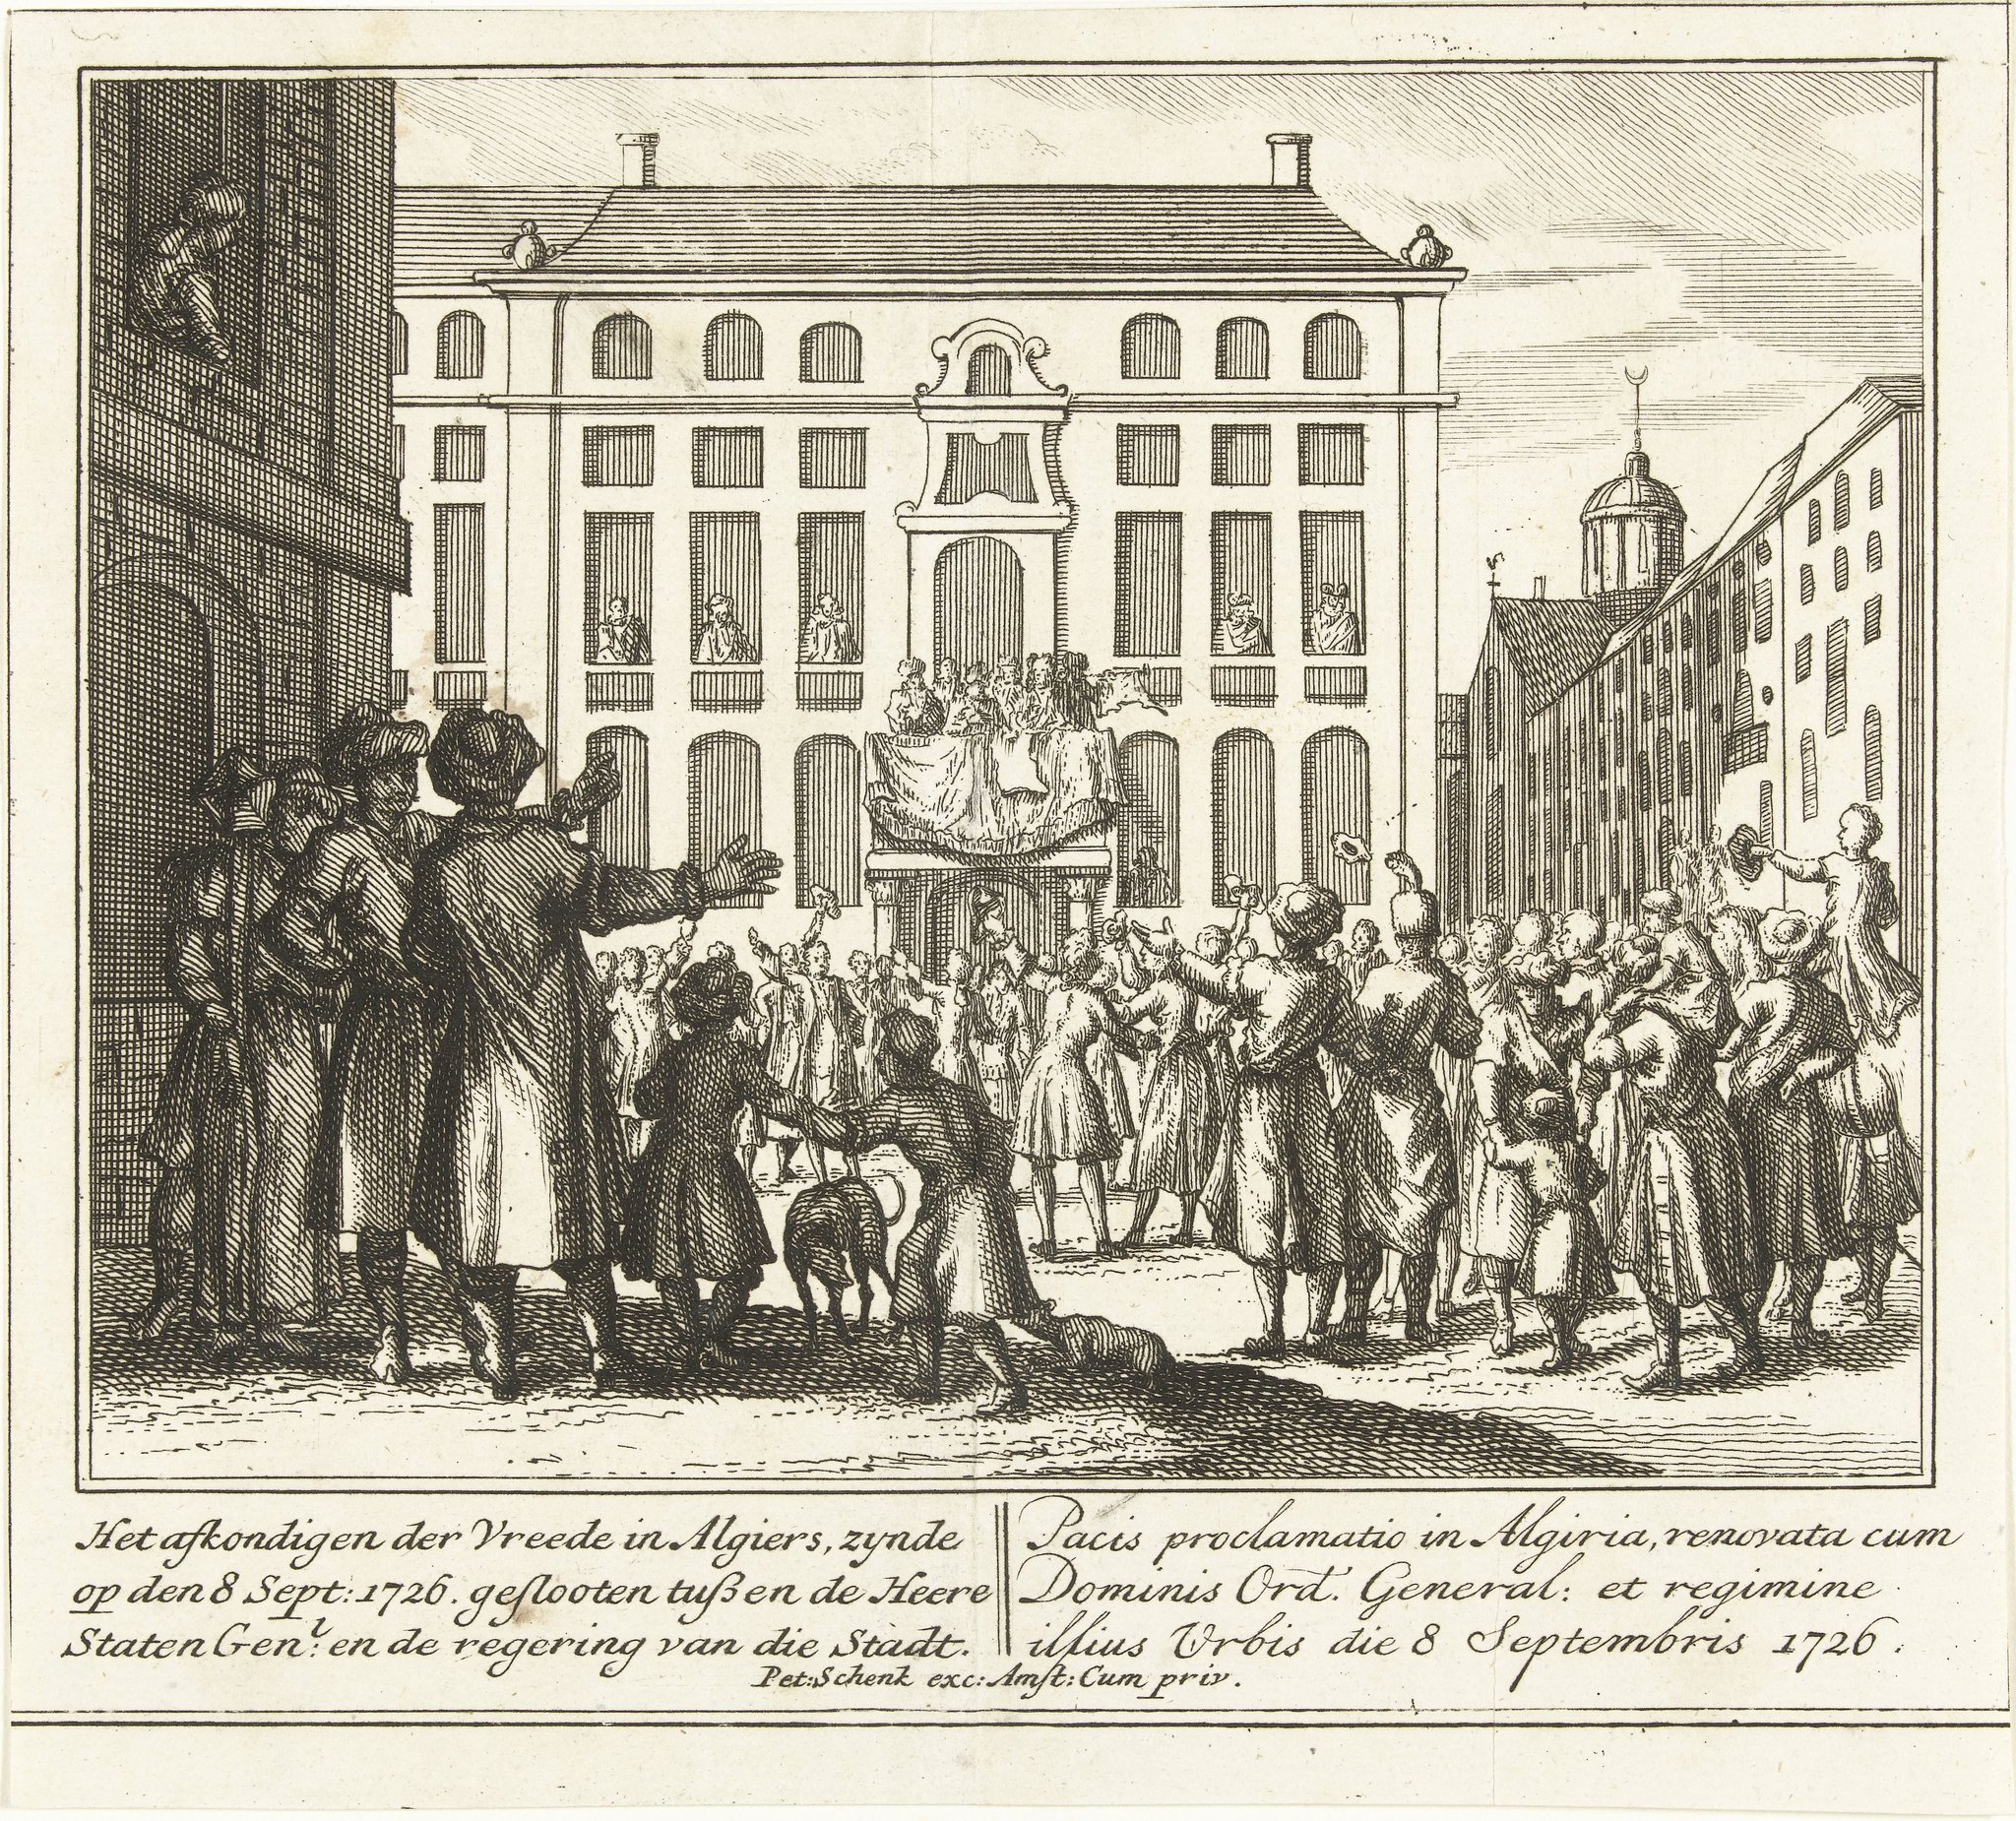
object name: print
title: Het afkondigen der Vreede in Algiers, zynde op den 8 Sept: 1726. geslooten tussen de Heere Staten Genl: en de regering van die Stadt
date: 1726-1727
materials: paper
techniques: etching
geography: amsterdam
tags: proclamation of peace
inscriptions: collector's mark: Lugt 2228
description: Dit nummer is een door het RPK toegevoegd nummer en staat niet in Frederik Muller, het werk waar de prent voor is gemaakt of uit afkomstig is, staat wel vermeld in Frederik Muller. Gebruikt als illustratie in: Schouwtoneel van den oorlog ..., J. Roman, Amsterdam 1727.